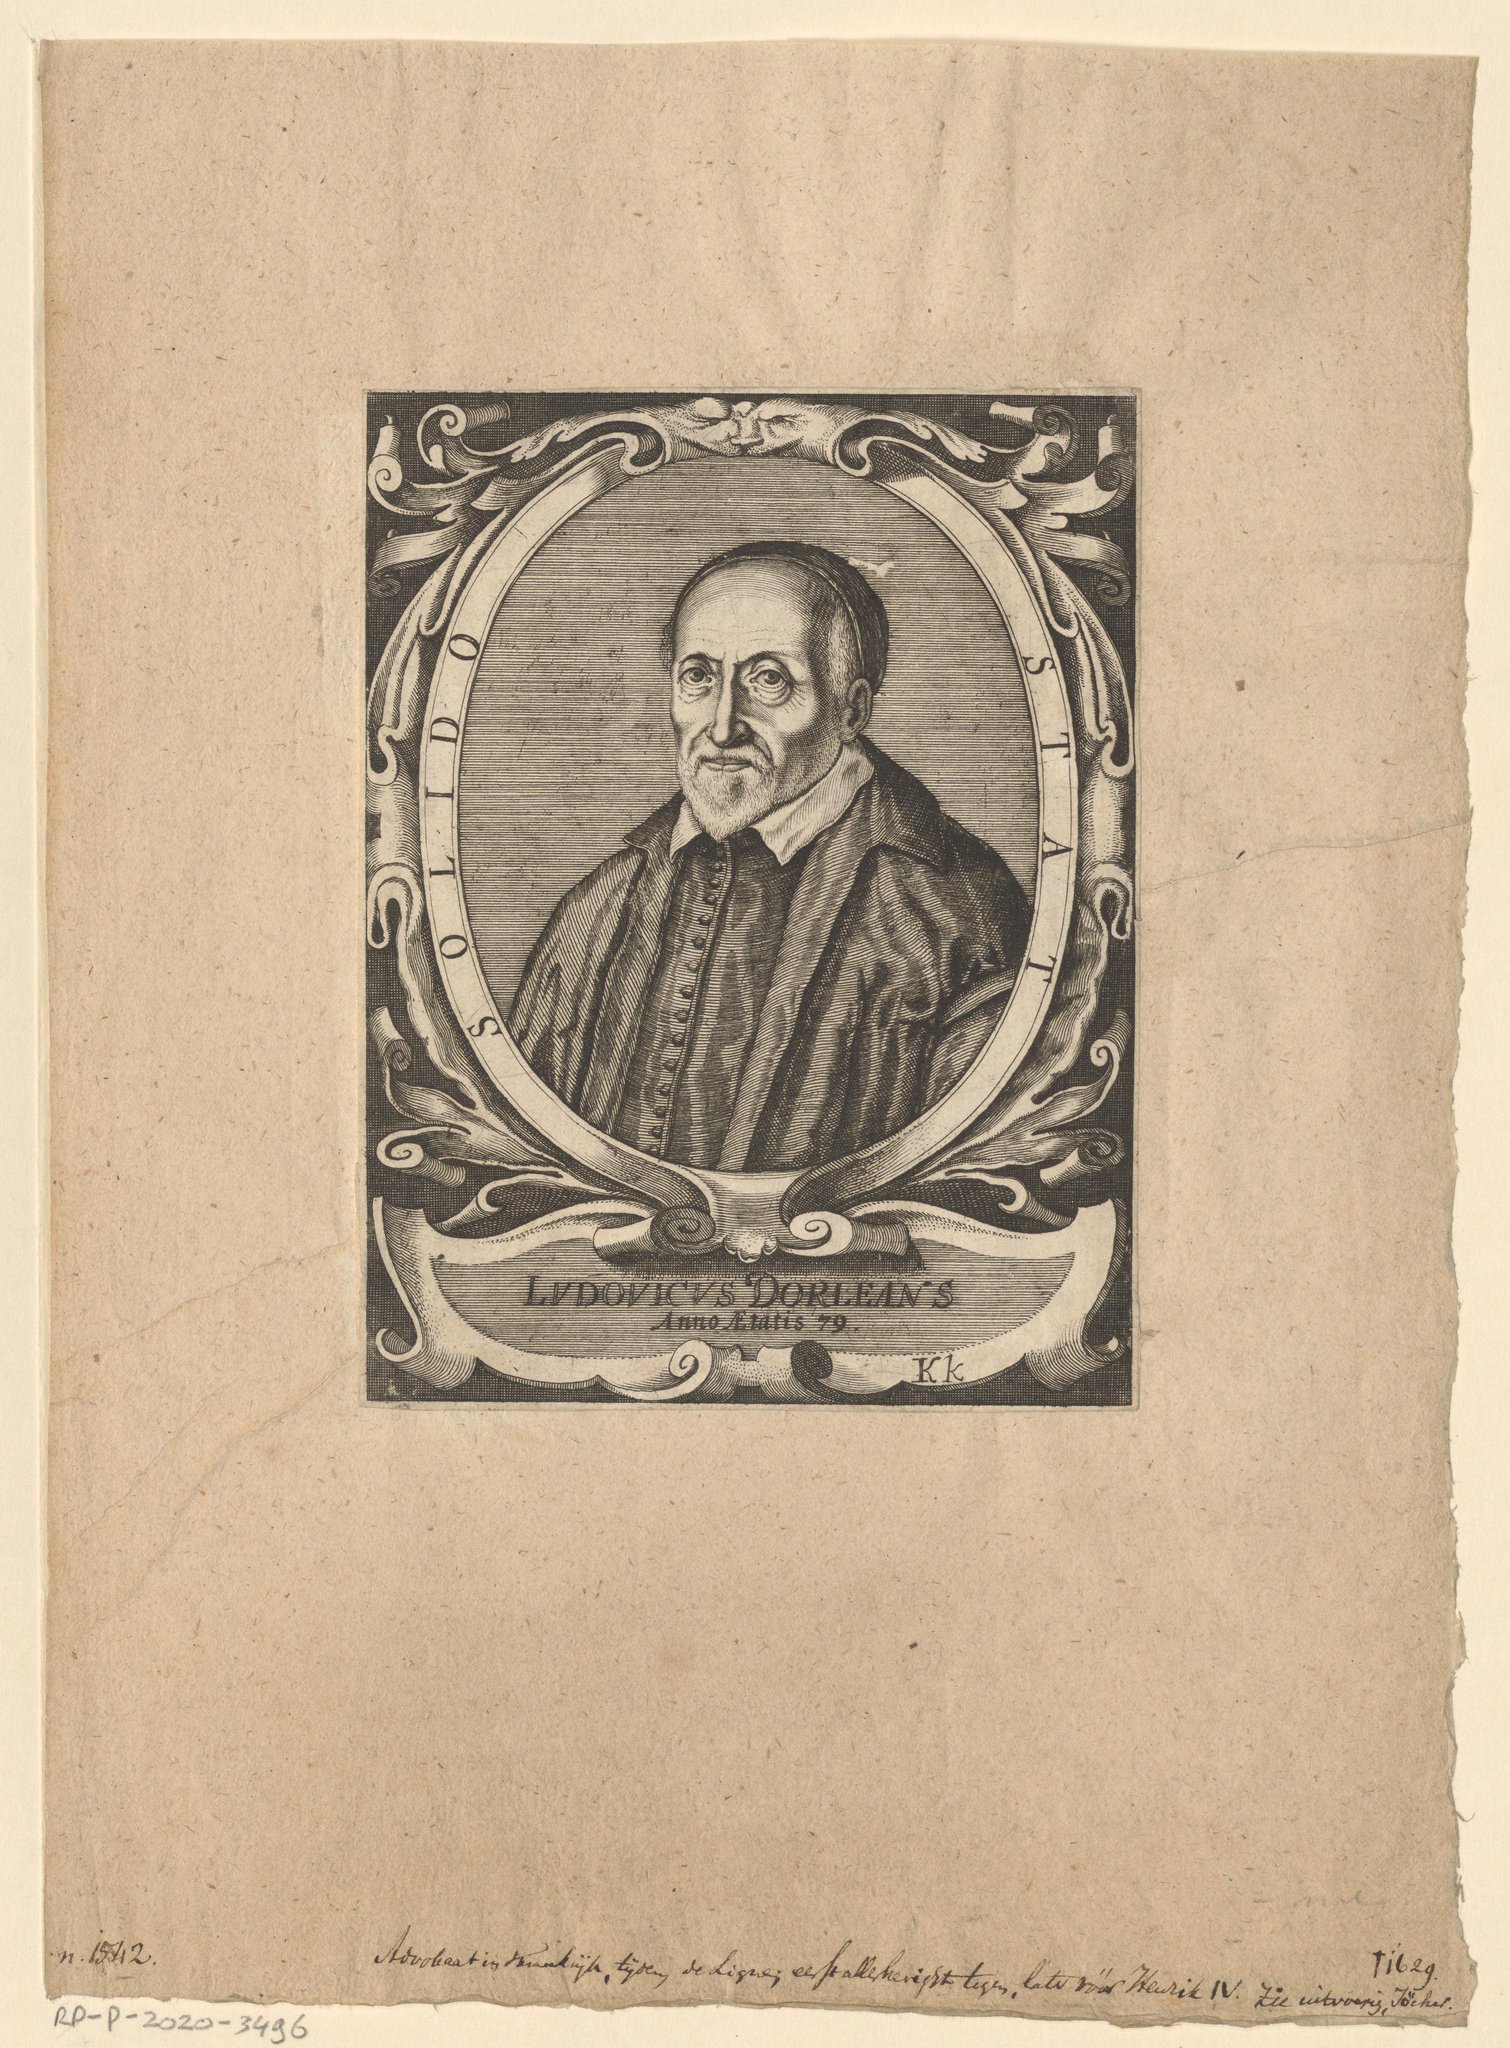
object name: print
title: Portret van Louis Dorléans op 79-jarige leeftijd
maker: Anonymous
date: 1650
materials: paper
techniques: engraving, etching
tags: paris, historical persons, lawyer, attorney at law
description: Prent waarschijnlijk uit: Bibliotheca chalcographica. Frankfurt am Main: Johannes Ammon, 1650.